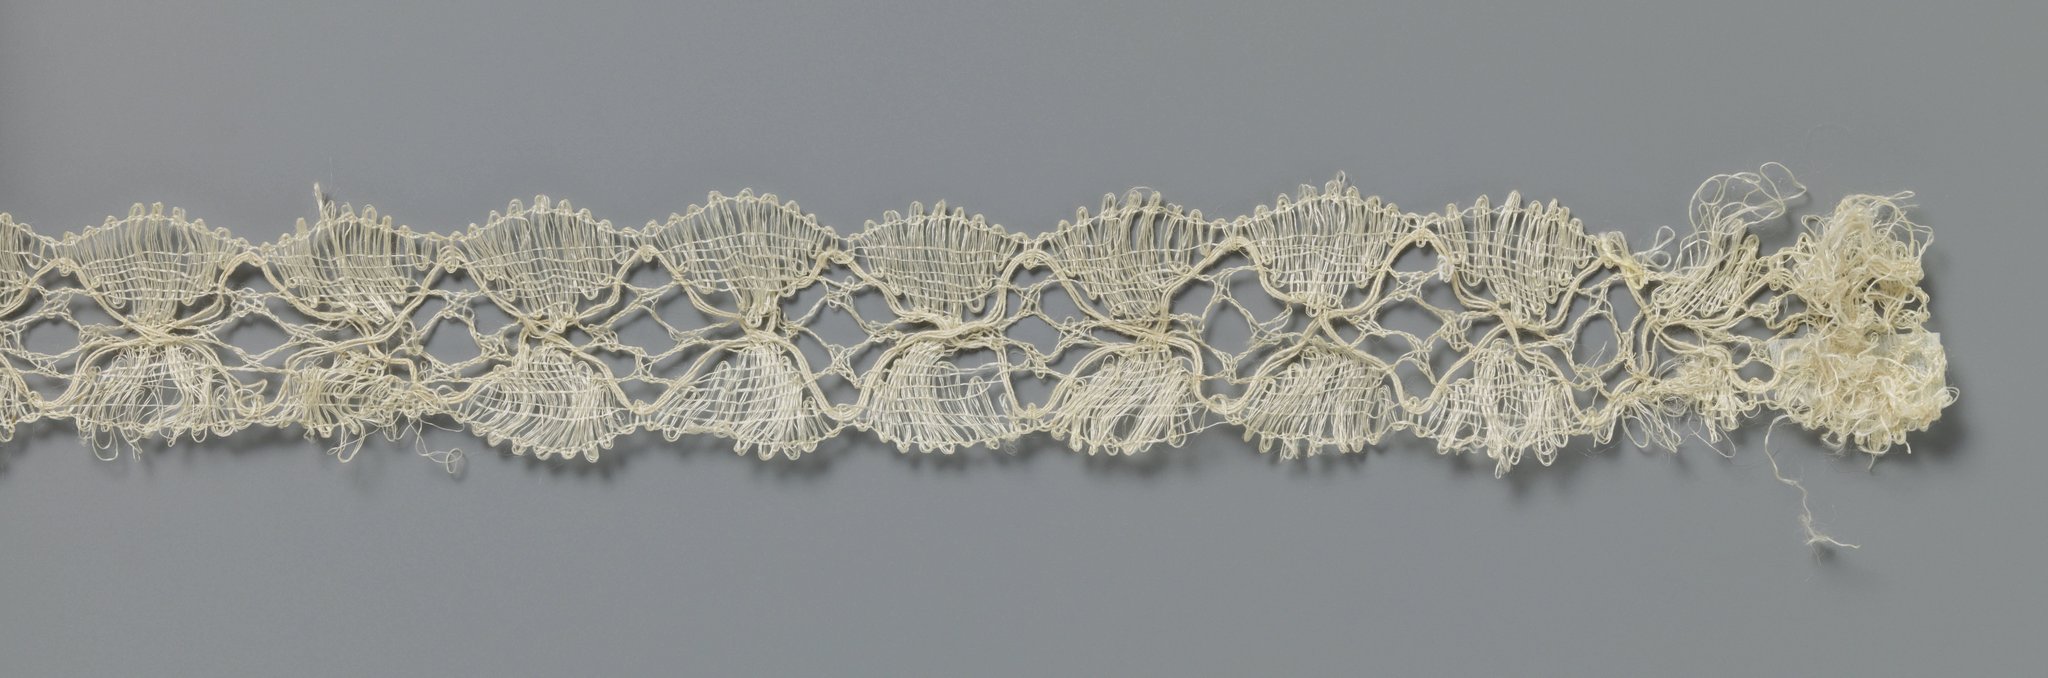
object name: strip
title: Strook kloskant met ruitvormig veld tussen gespiegelde waaiers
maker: Anonymous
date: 1840-1860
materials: silk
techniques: lace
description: Strook naturelkleurige kloskant, blonde. Het zich herhalende patroon bestaat uit een over de lengte-as gespiegelde waaier, die aan de boven- en onderzijde van de strook schulpen vormen. Tussen de gespiegelde waaiers in wordt een opengewerkt ruitvormig veld gevormd, waarin een siergrond is toegepast. De ruiten zijn voorzien van doorlopende contourdraden, die elkaar kruisen op de lengte-as.